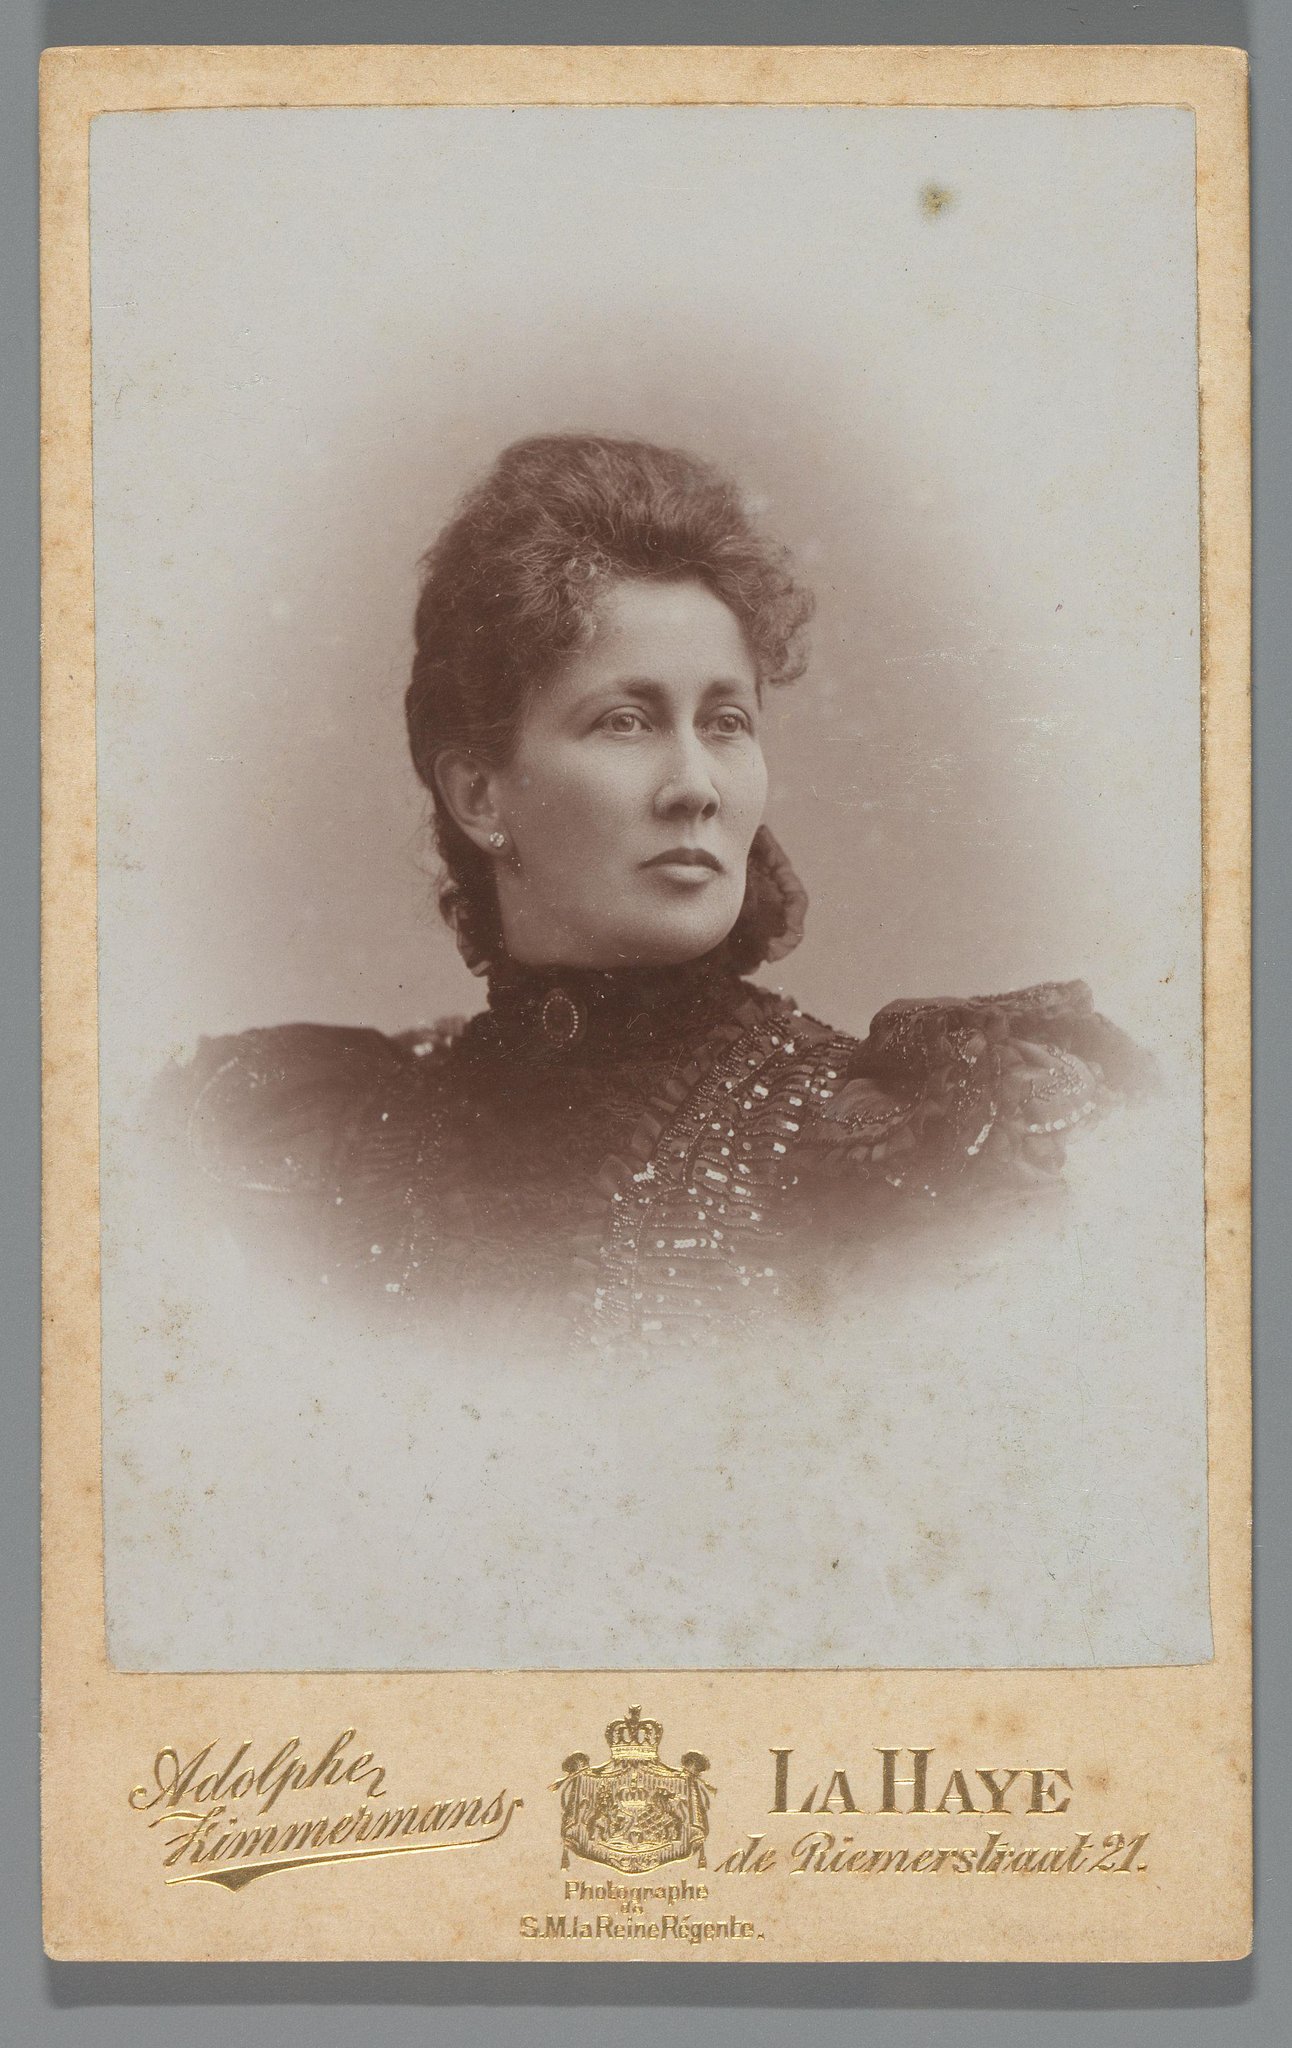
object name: carte de visite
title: Portret van mevrouw Holle-van Motman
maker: adolphe zimmermans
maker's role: fotograaf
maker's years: 1858-1922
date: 1870-1920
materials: cardboard, photographic support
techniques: albumen print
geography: the hague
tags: mevrouw holle-van motman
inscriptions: name: ‘Adolphe / Zimmermans / LA HAYE / de Riemer Straat 21.’, name: ‘Holle - / van Motman’